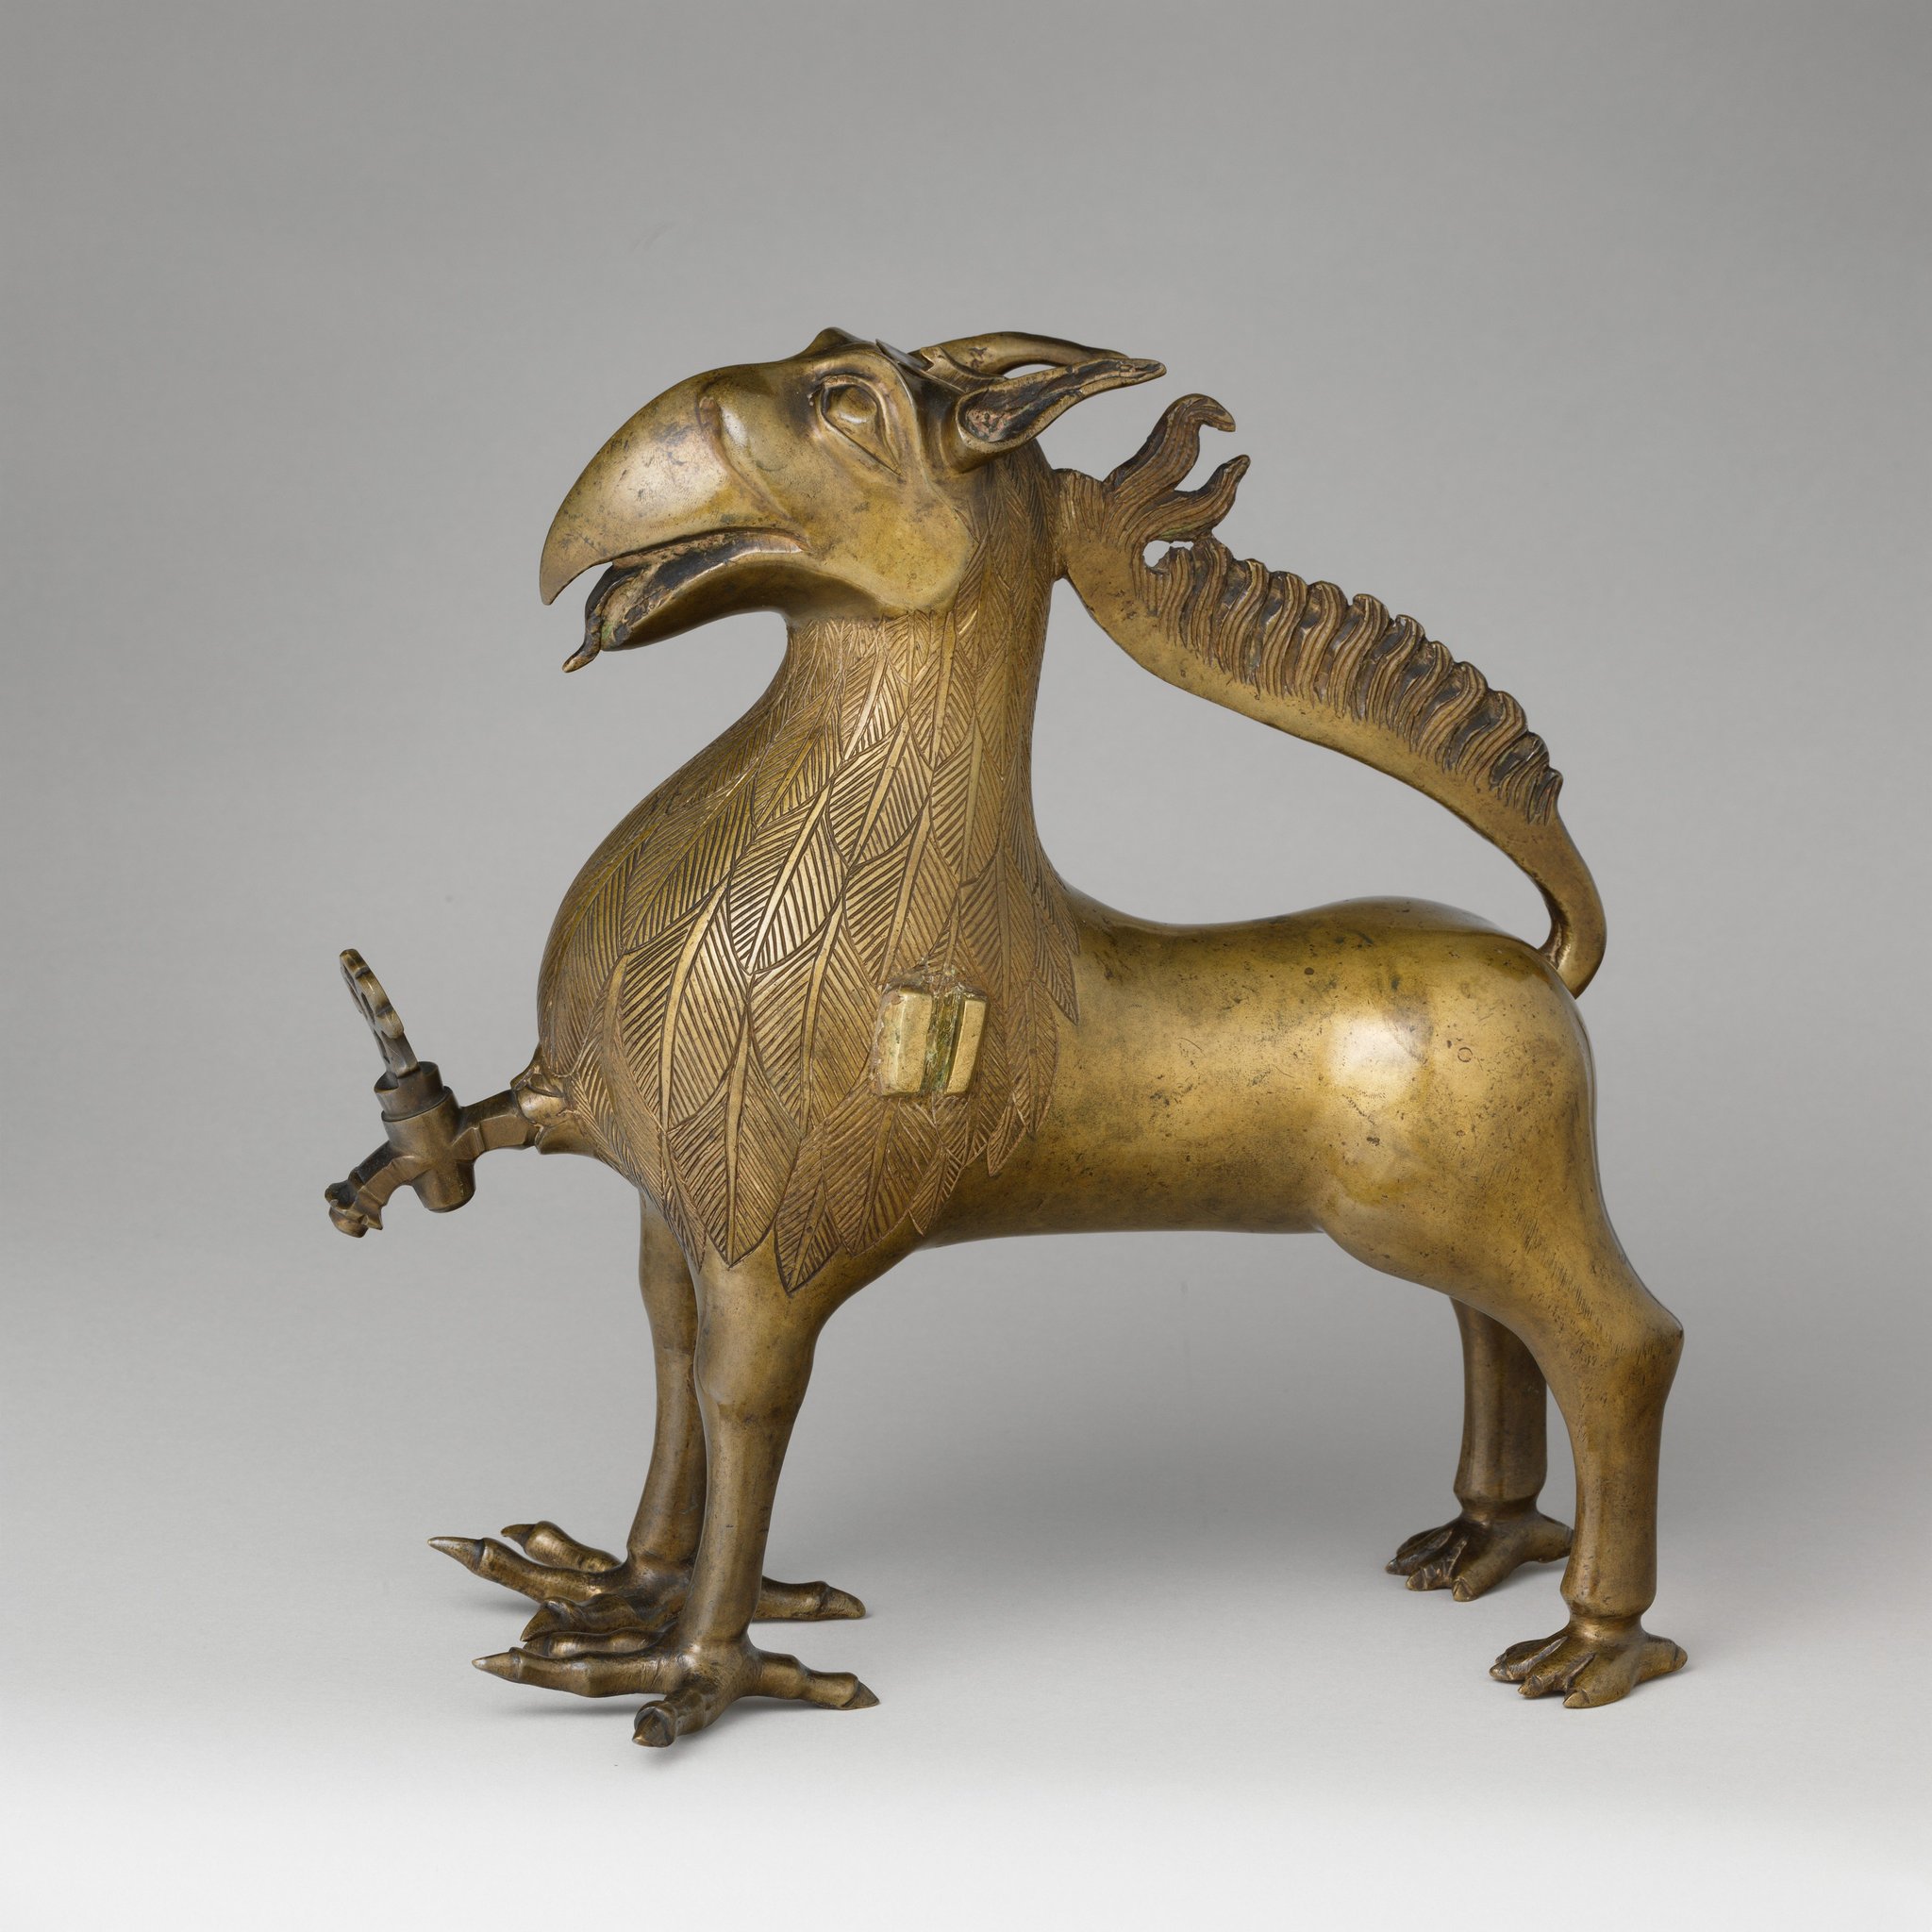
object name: aquamanile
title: Aquamanile in the Form of a Griffin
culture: german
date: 1425-1450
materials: bronze, copper, copper alloy, lead, patina, zinc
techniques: casting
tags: griffins